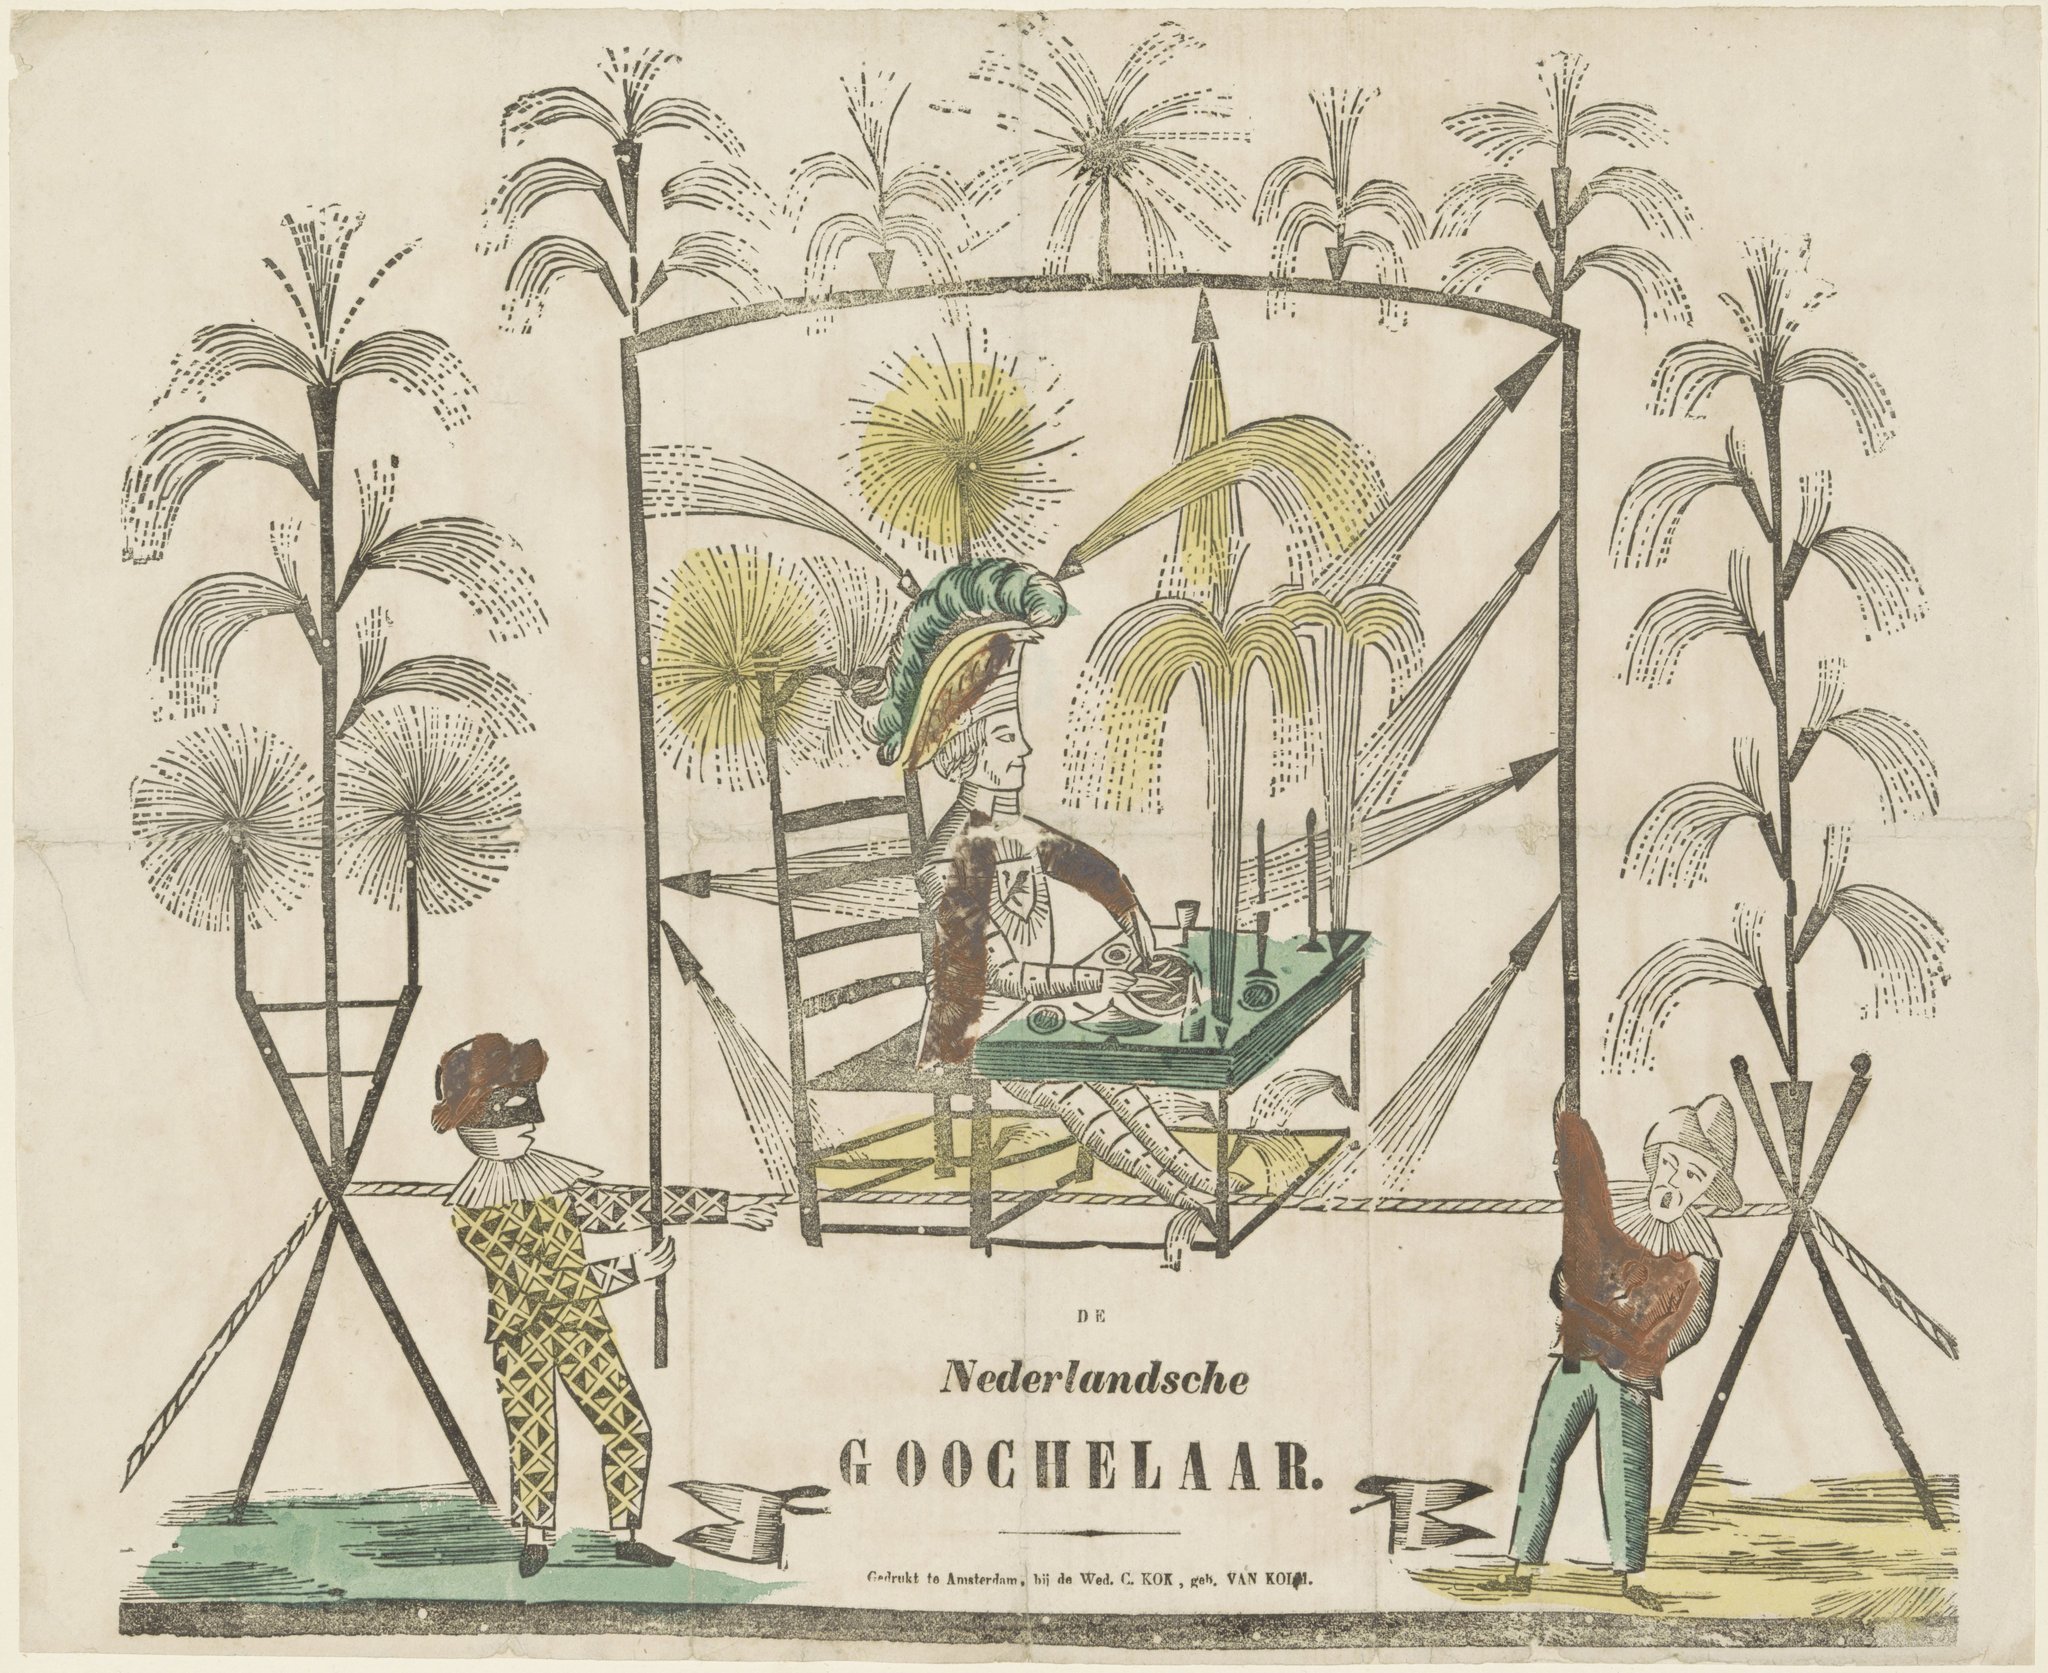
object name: popular print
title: De Nederlandsche goochelaar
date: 1842-1866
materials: paper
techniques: colour, letterpress printing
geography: netherlands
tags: sorcerer, magician, wizard, warlock, clown, bonfire, fire-works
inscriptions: collector's mark: Lugt 2760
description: Een goochelaar zittend aan een tafel, balancerend op een koord. Twee clowns dragen een stellage waar aan alle kanten vuurwerk uit komt.